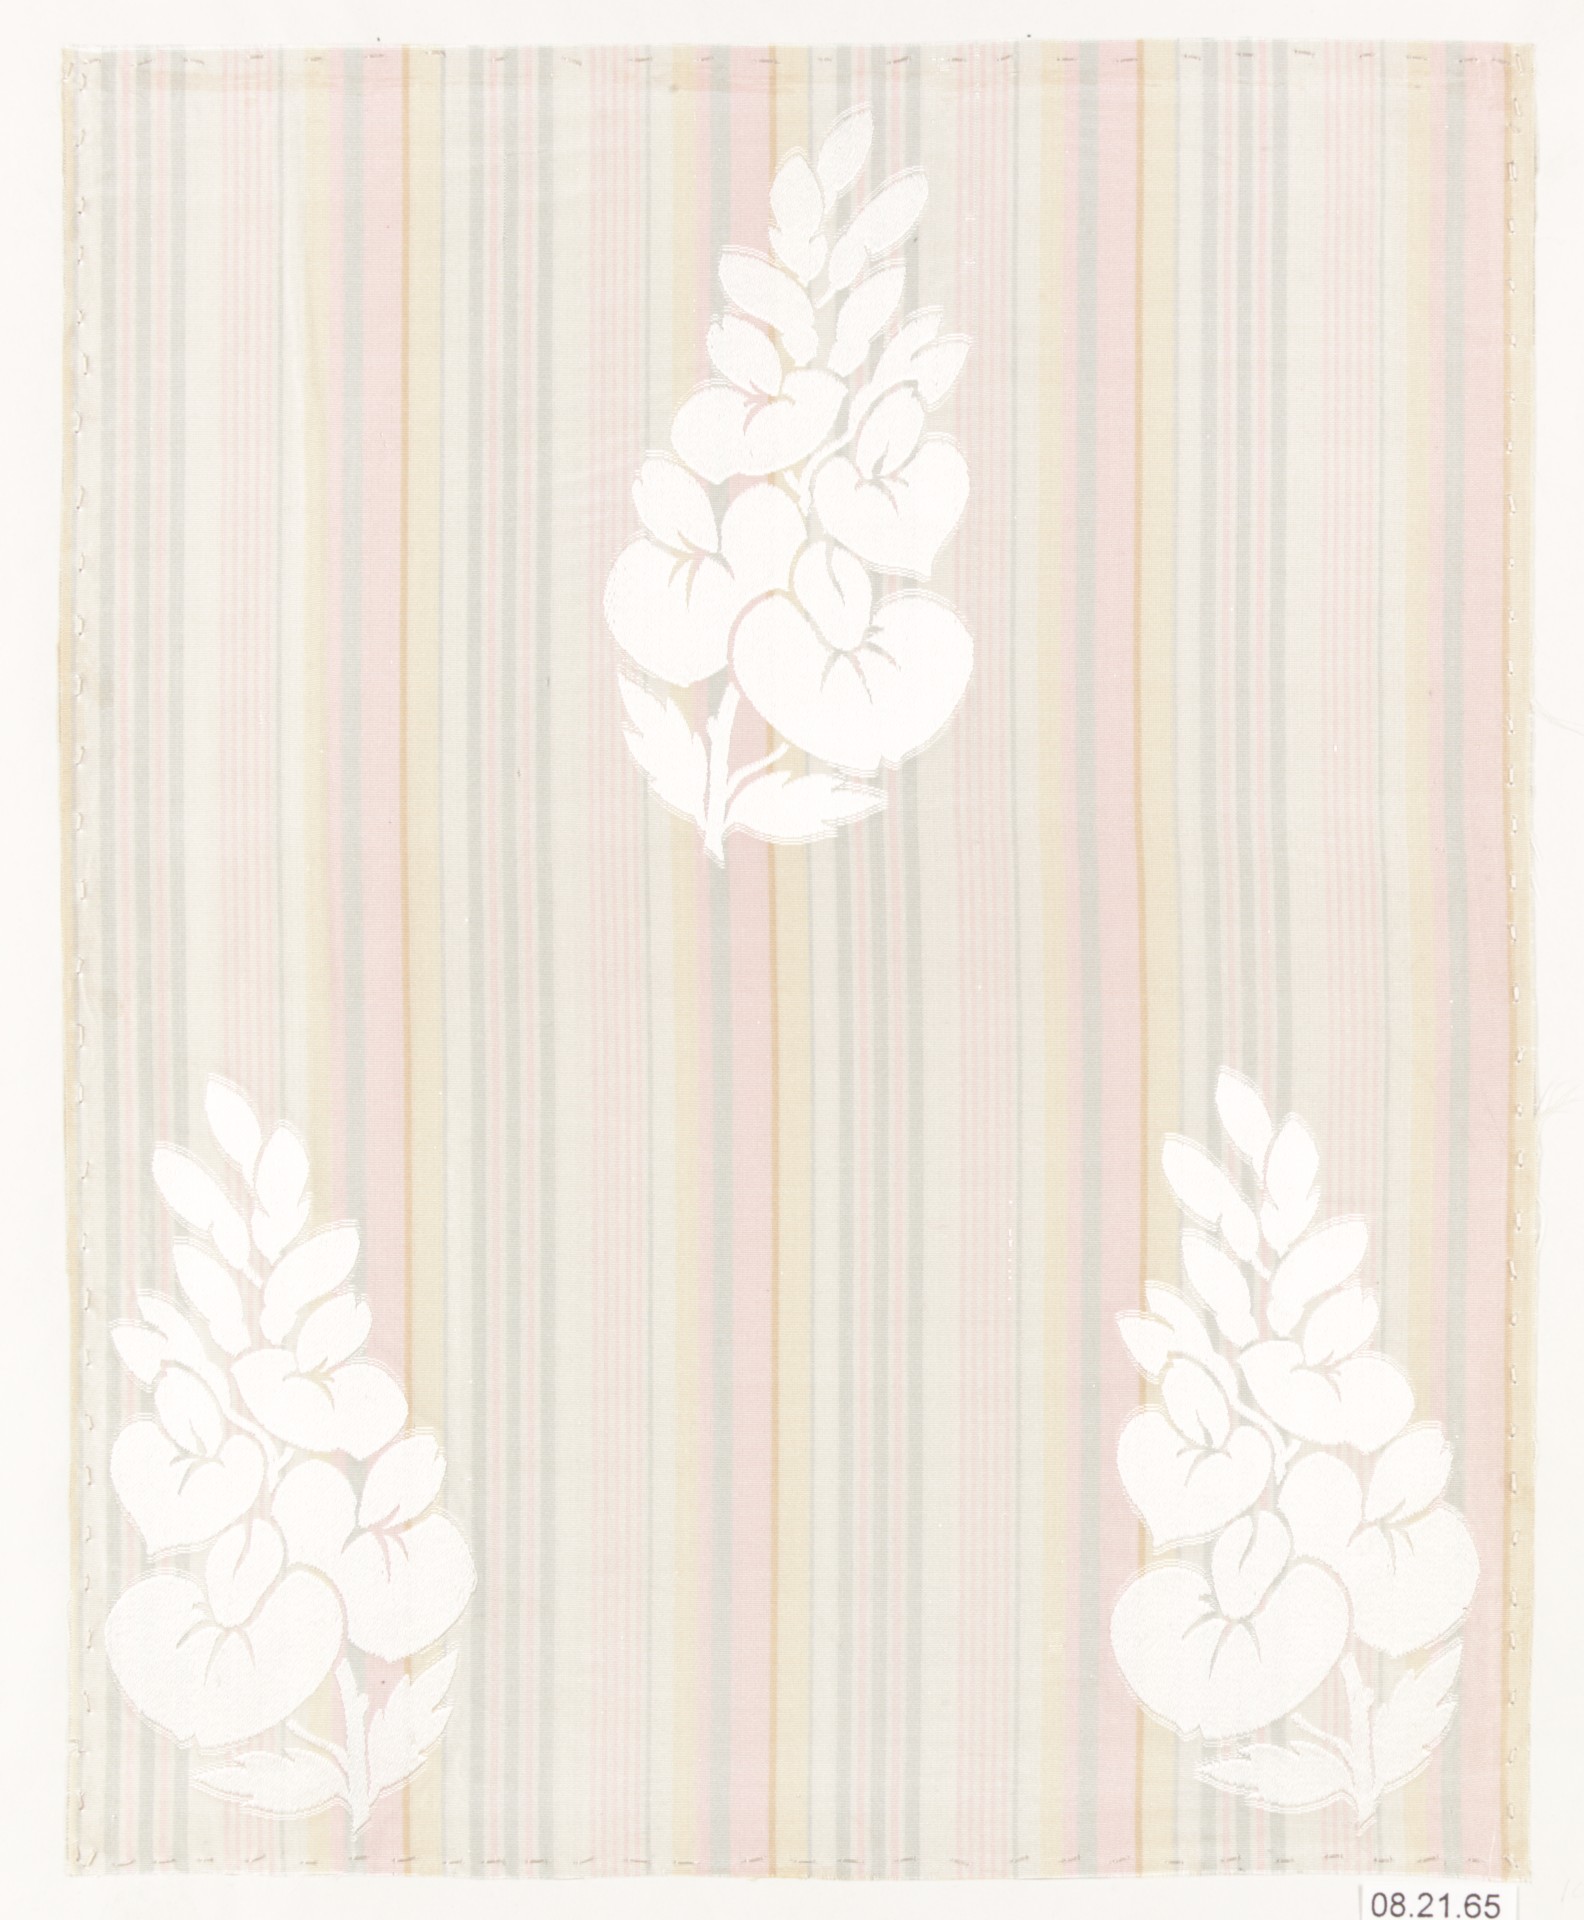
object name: textile sample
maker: Anonymous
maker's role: designer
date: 1900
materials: silk